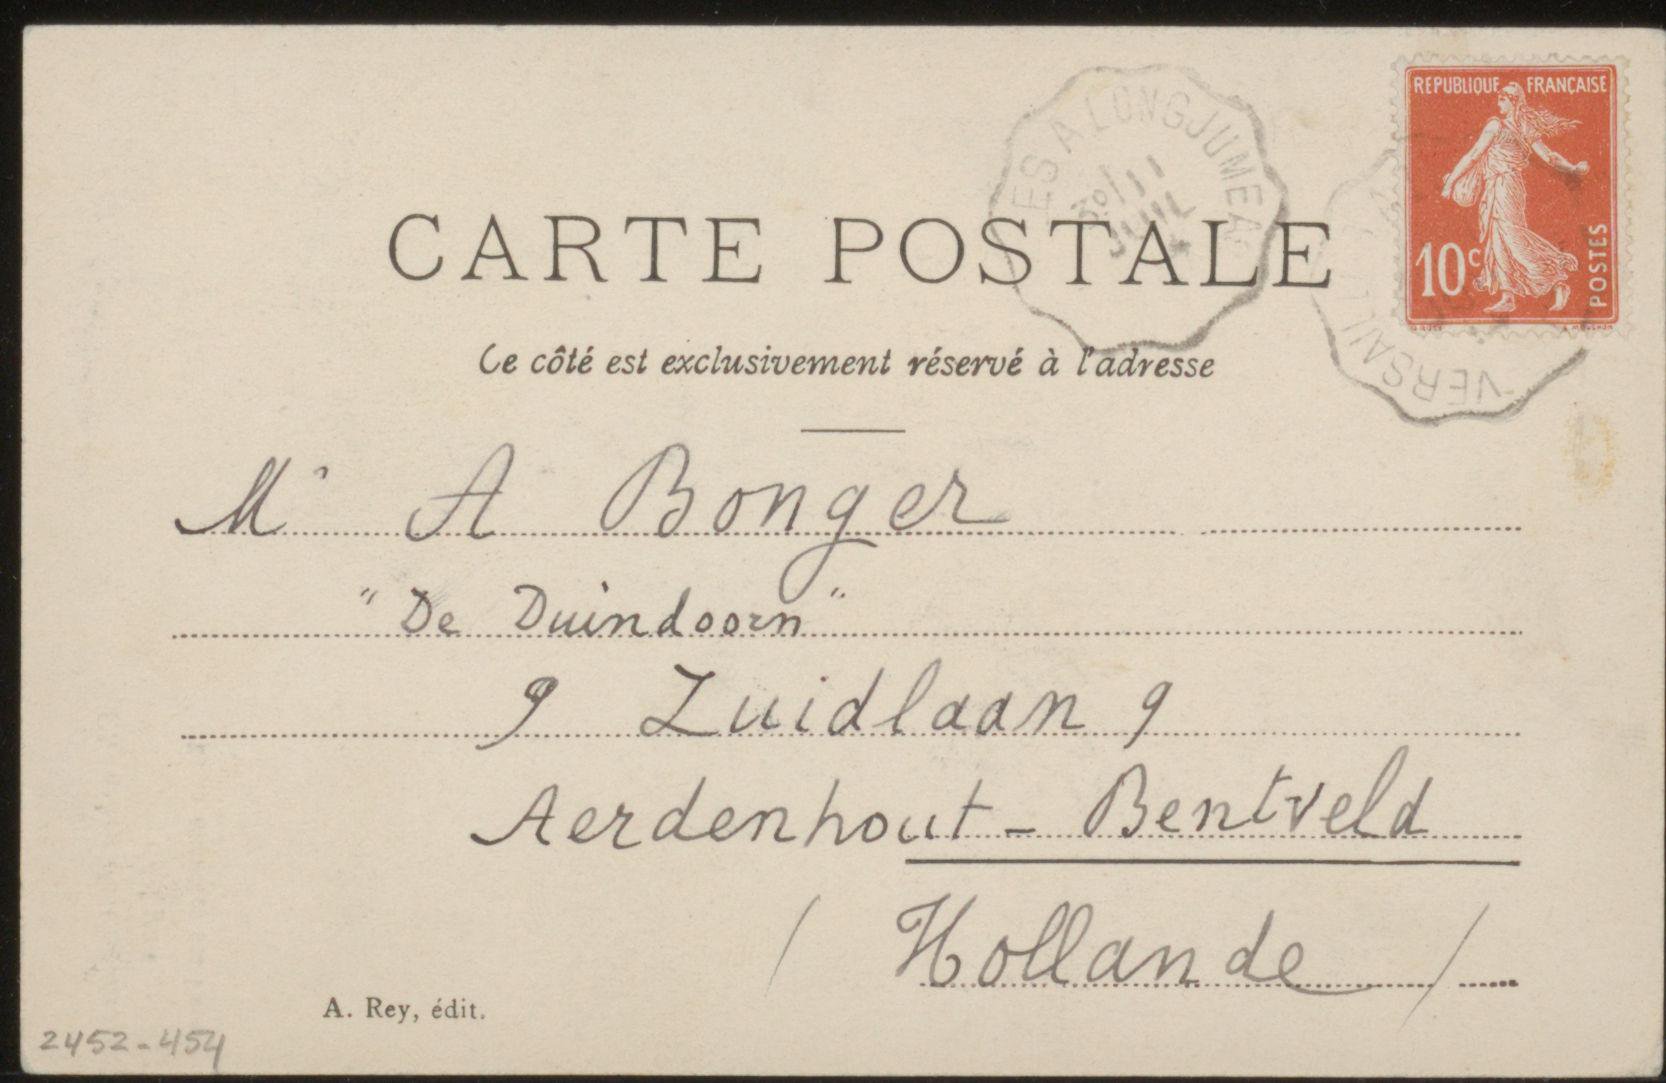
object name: ansichtkaart, prentbriefkaart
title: Prentbriefkaart aan Andries Bonger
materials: cardboard, ink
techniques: photograph, pen, writing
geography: bièvres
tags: andries bonger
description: Prentbriefkaart behoort tot een album samengesteld door weduwe Françoise W.M. Barones van der Borch van Verwolde met afschriften van brieven met betrekking tot (de familie van) Odilon Redon. De prentbriefkaart werd bewaard op pagina 103.